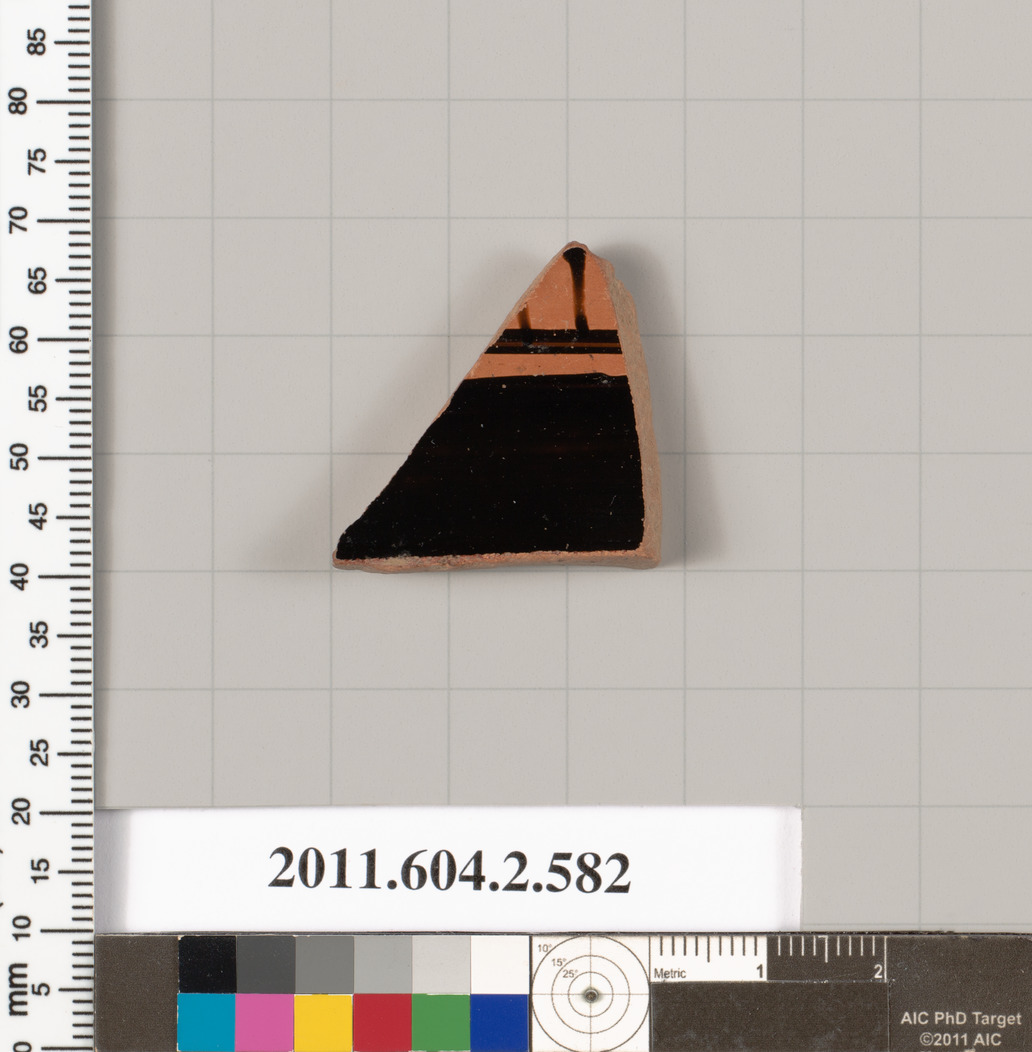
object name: column krater fragment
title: Terracotta fragment of a column-krater (bowl for mixing wine and water)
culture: greek, attic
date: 460-440 BCE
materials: terracotta